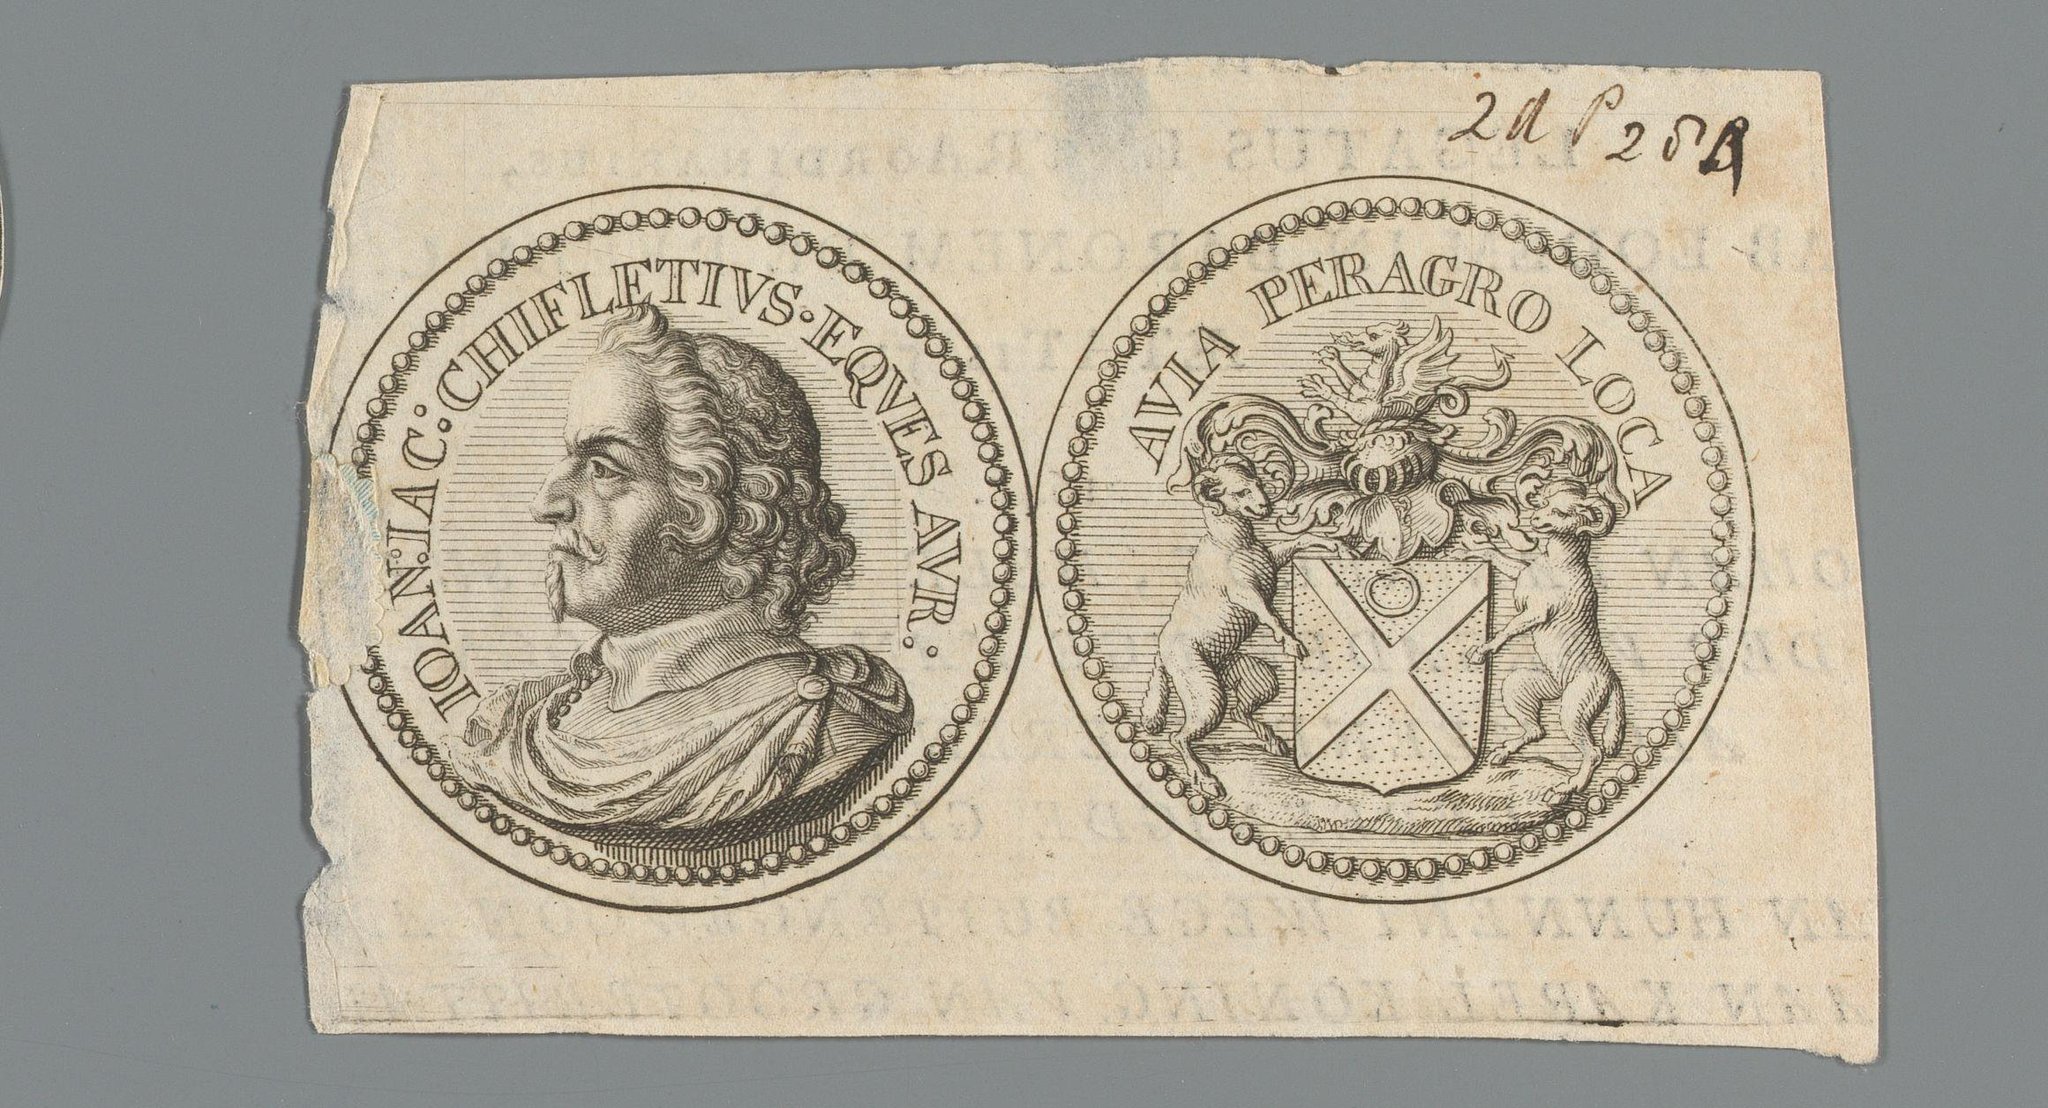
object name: print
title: Voor- en achterzijde van een penning met daarop het portret van Jean-Jacques Chifflet en zijn wapenschild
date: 1726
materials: paper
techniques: etching, letterpress printing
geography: the hague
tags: jean-jacques chifflet, coat of arms (symbol of sovereignty), historical persons, physician, doctor, coin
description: Prent uit: Loon, Gerard van. Beschryving der Nederlandsche Historipenningen: (...). Den Haag: Christiaan van Lom et al., 1726, dl. 2, p. 284.